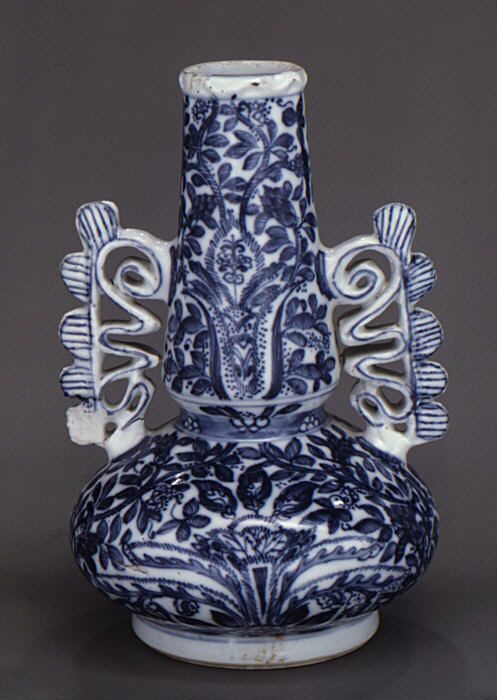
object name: vase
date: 1700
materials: hard paste porcelain